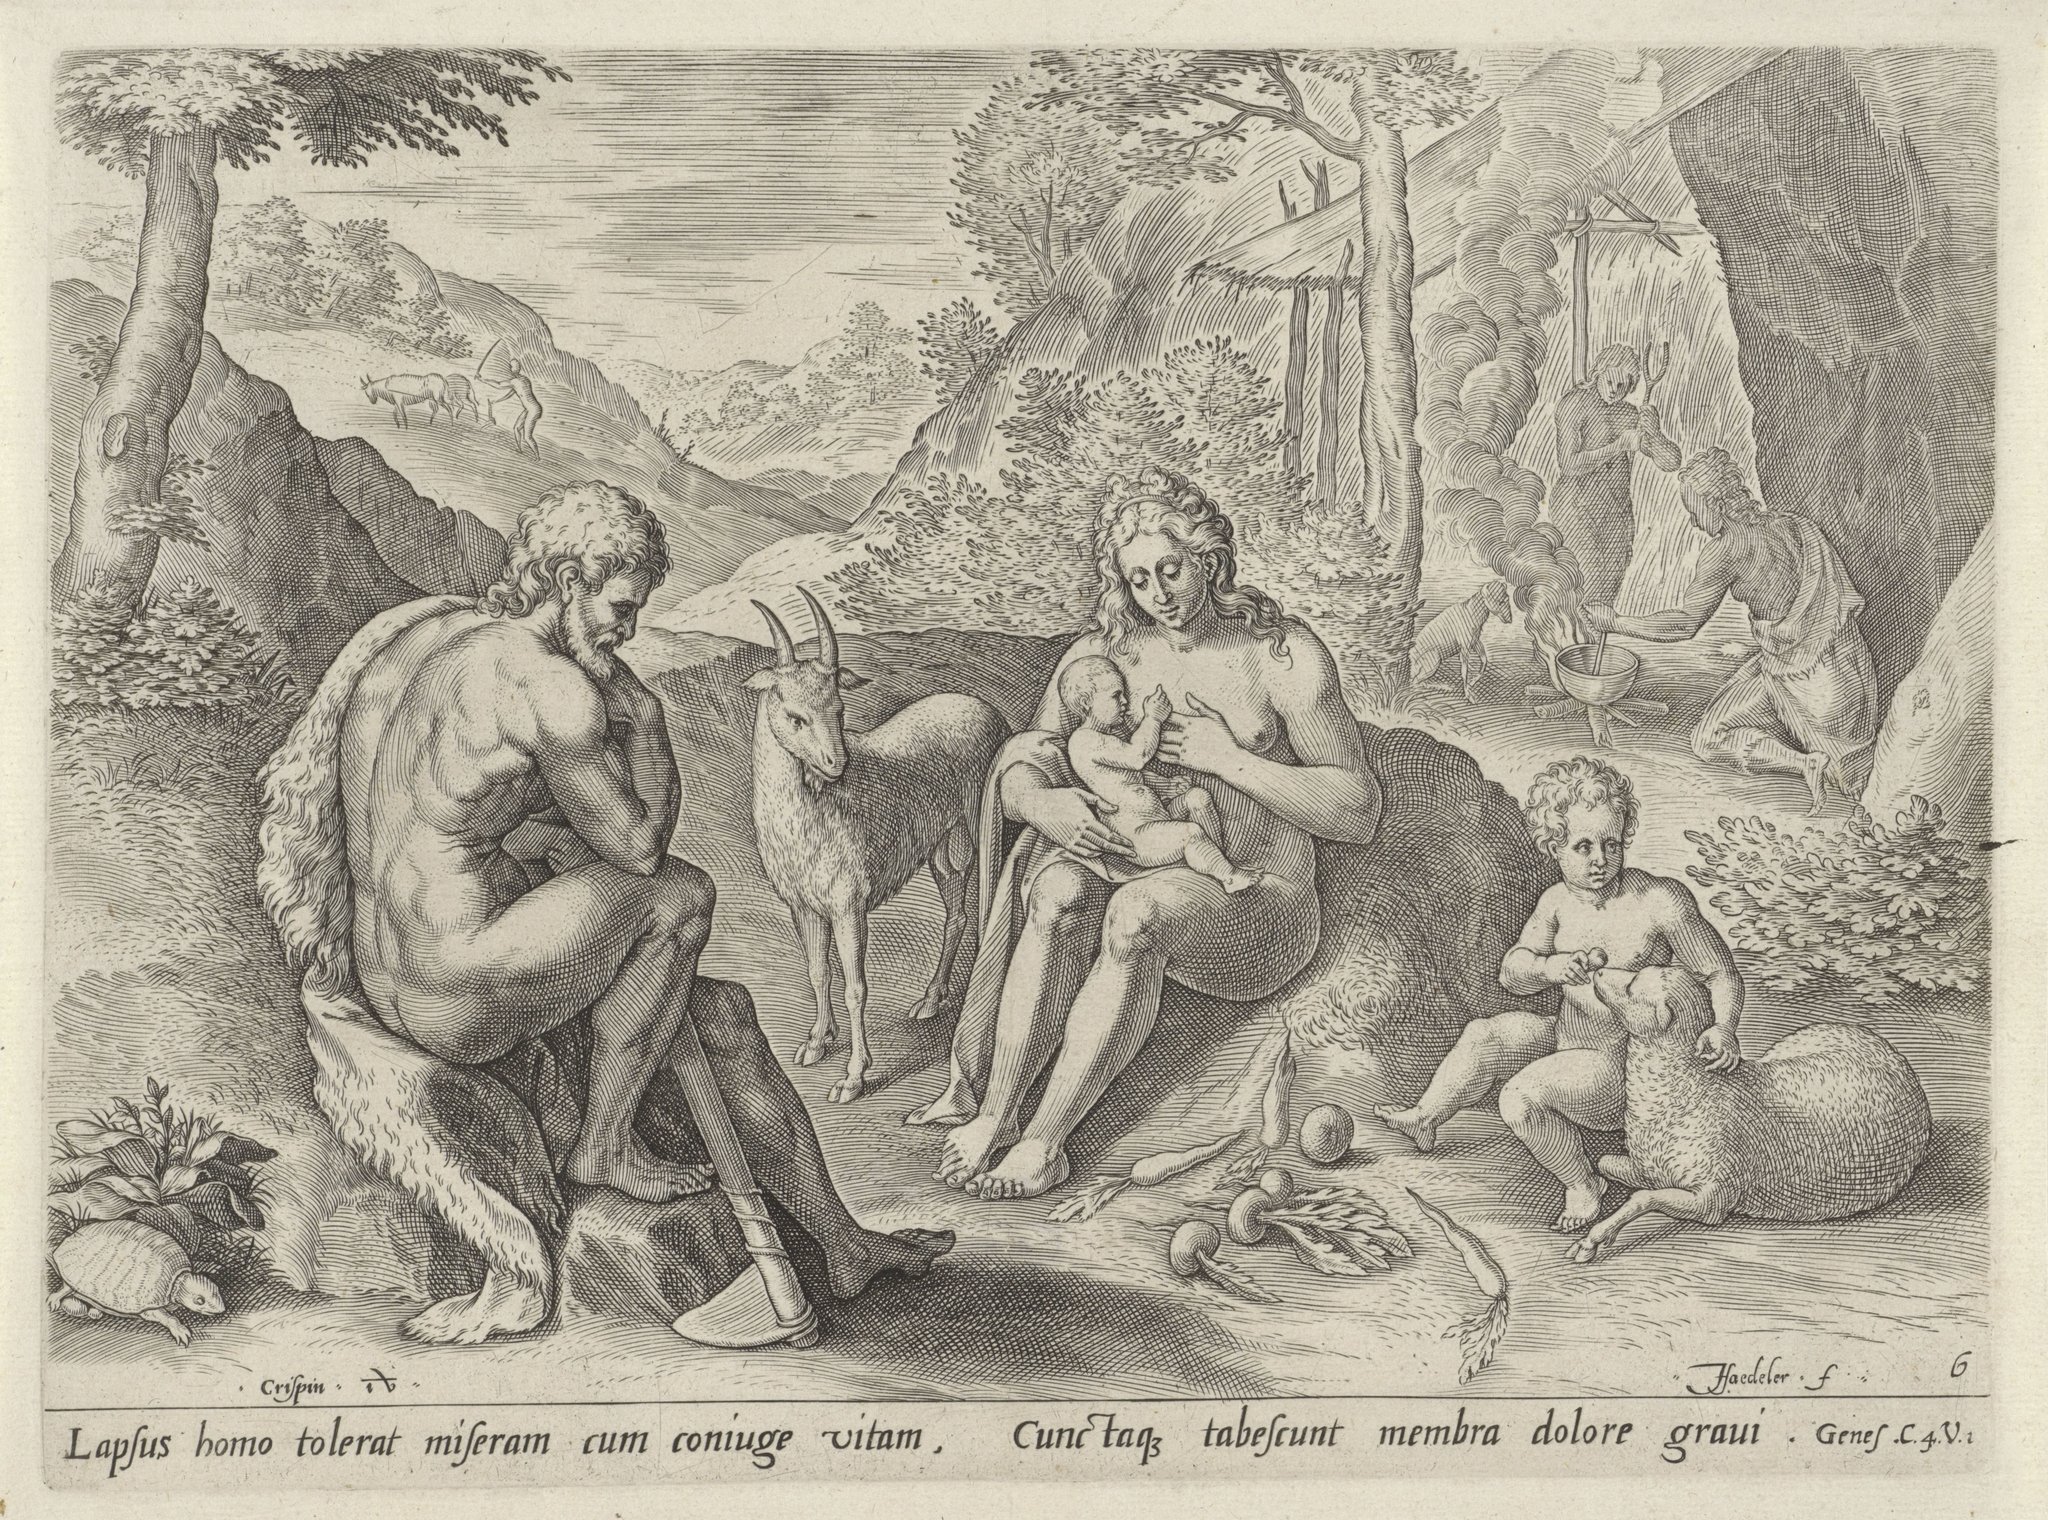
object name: print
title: Zondeval van de mens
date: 1575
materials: paper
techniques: engraving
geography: amsterdam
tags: adam (and eve) engaged in agricultural activities, eve suckling abel; cain turns aside, i.e. the jealousy of cain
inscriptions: collector's mark: Lugt 2228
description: Adam en Eva en hun kinderen Kaïn en Abel in de wildernis buiten het Aards Paradijs. Adam rust van het werk dat hij dagelijks moet verrichten. Eva geeft Abel de borst. Kaïn geeft een schaap te eten. Op de achtergrond bewerkt Adam het land.